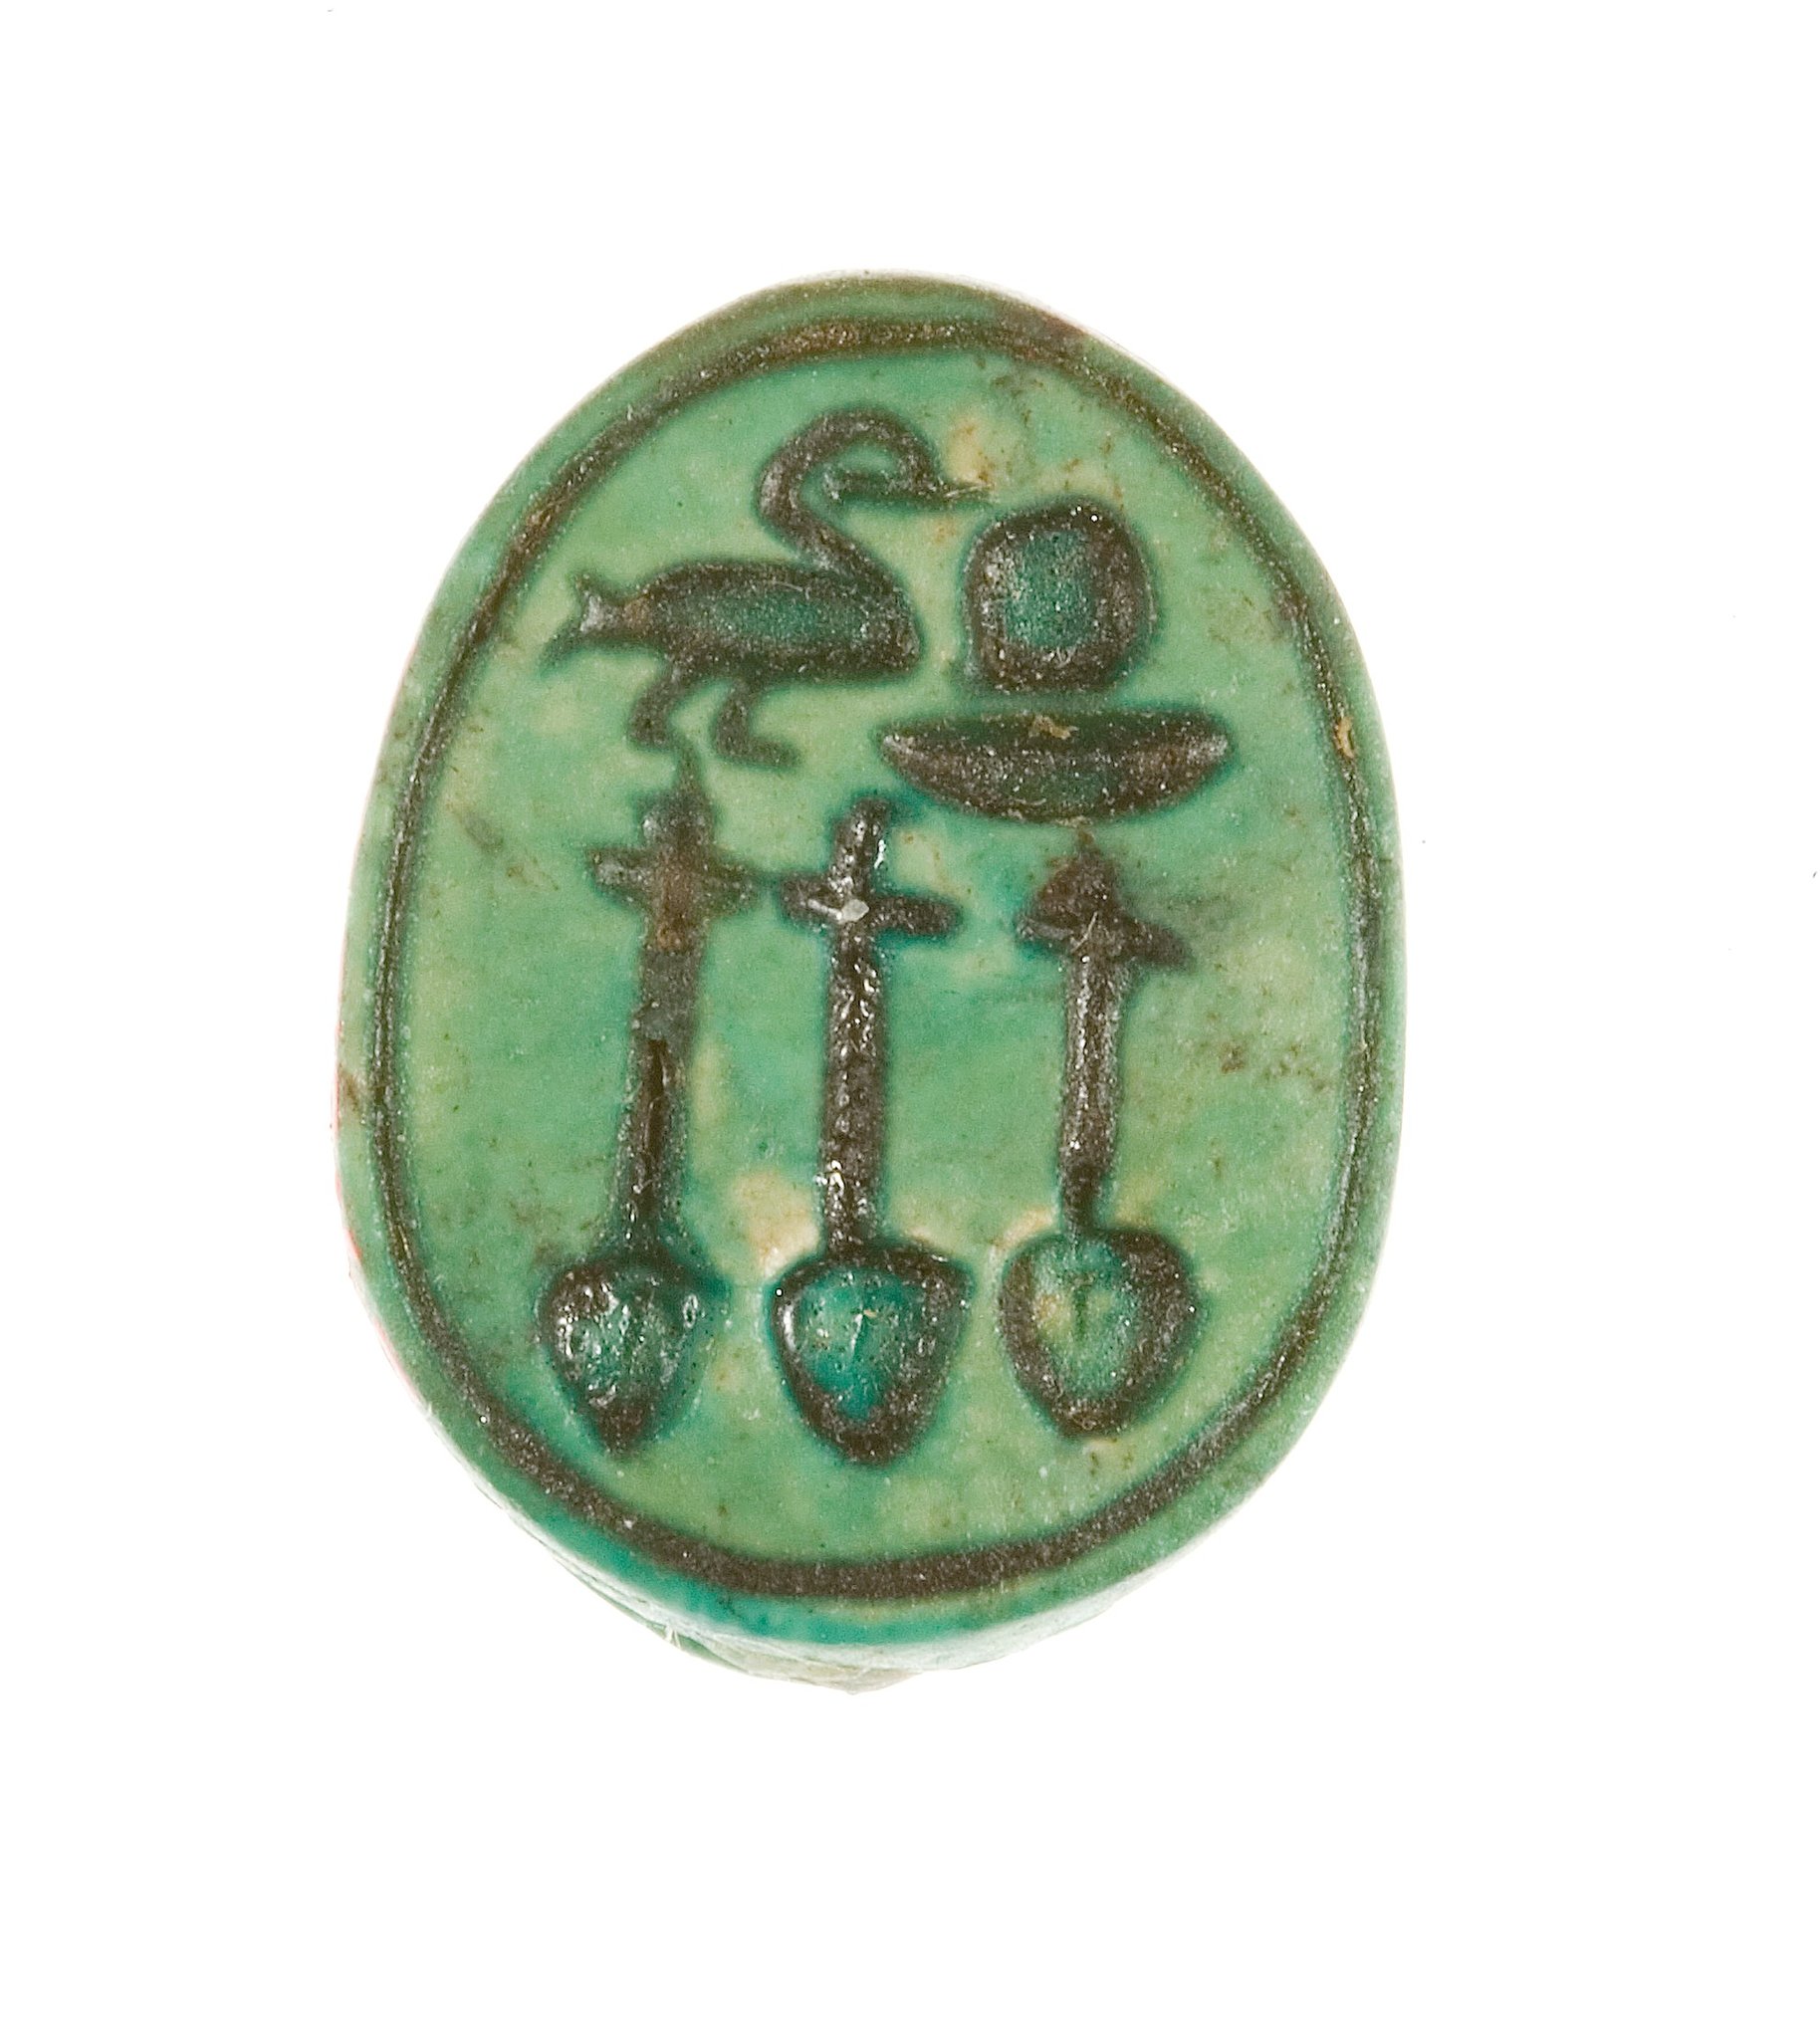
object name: scarab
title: Scarabs Inscribed for Neferure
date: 1479-1458 BCE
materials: stone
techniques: glazing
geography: egypt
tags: hieroglyphs,scarabs